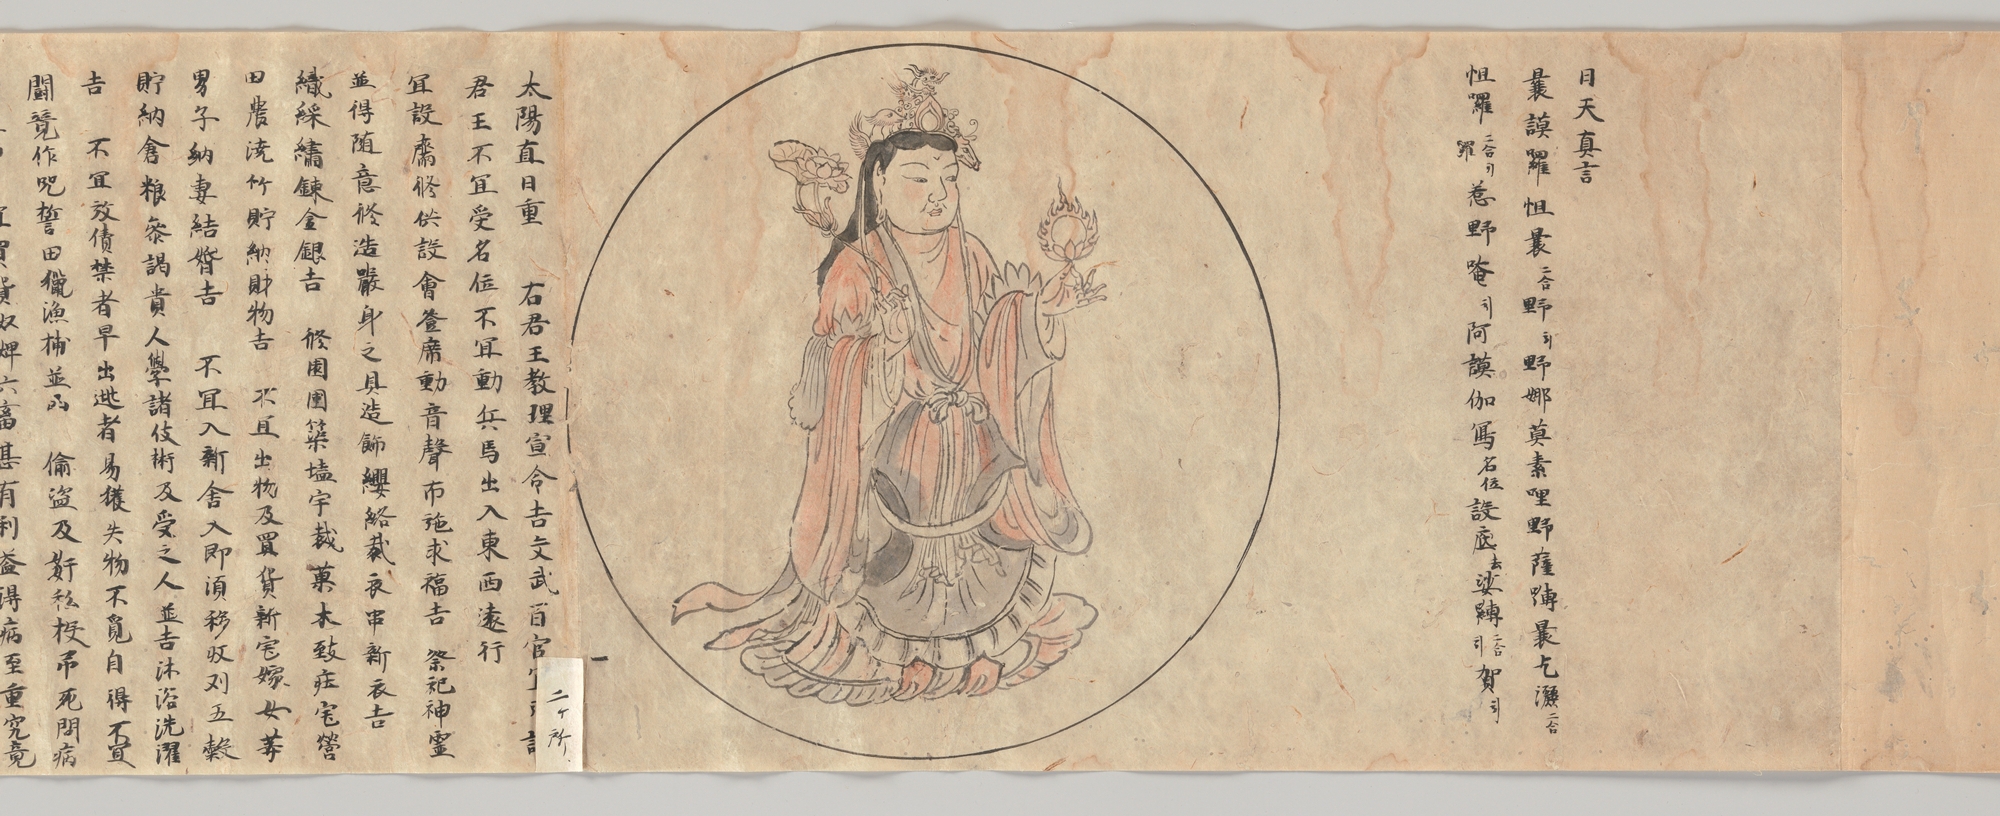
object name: handscroll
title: Iconographic Drawings of the Secrets of the Nine Luminaries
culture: japanese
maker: sōkan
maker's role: artist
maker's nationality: japanese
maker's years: 1050-1150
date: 1125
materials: ink, paper